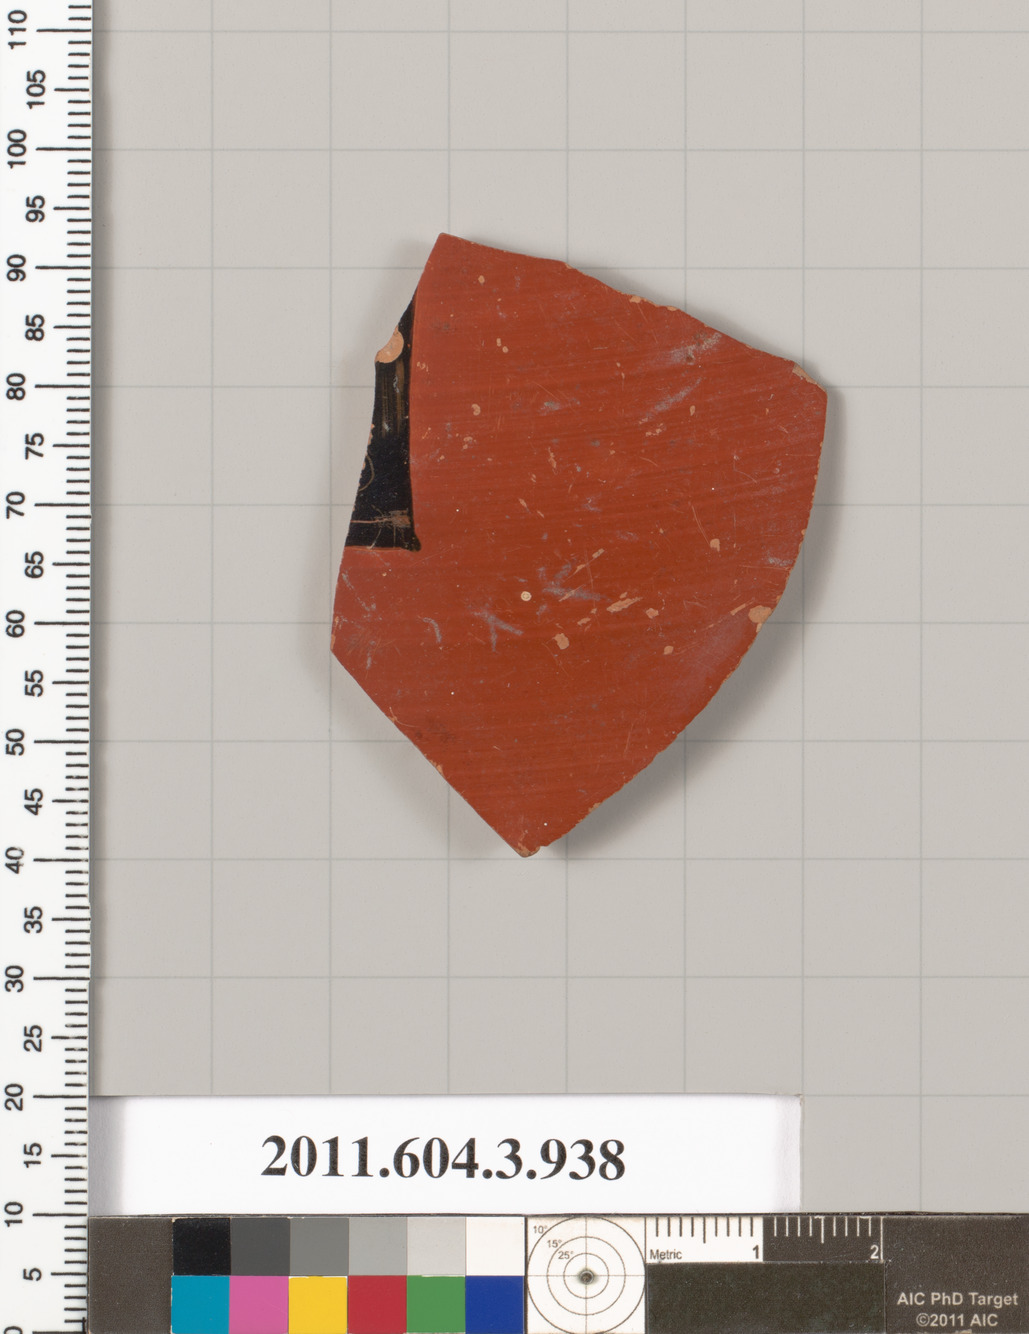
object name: undetermined shape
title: Terracotta fragment of an undetermined shape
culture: greek, attic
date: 525-501 BCE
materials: terracotta